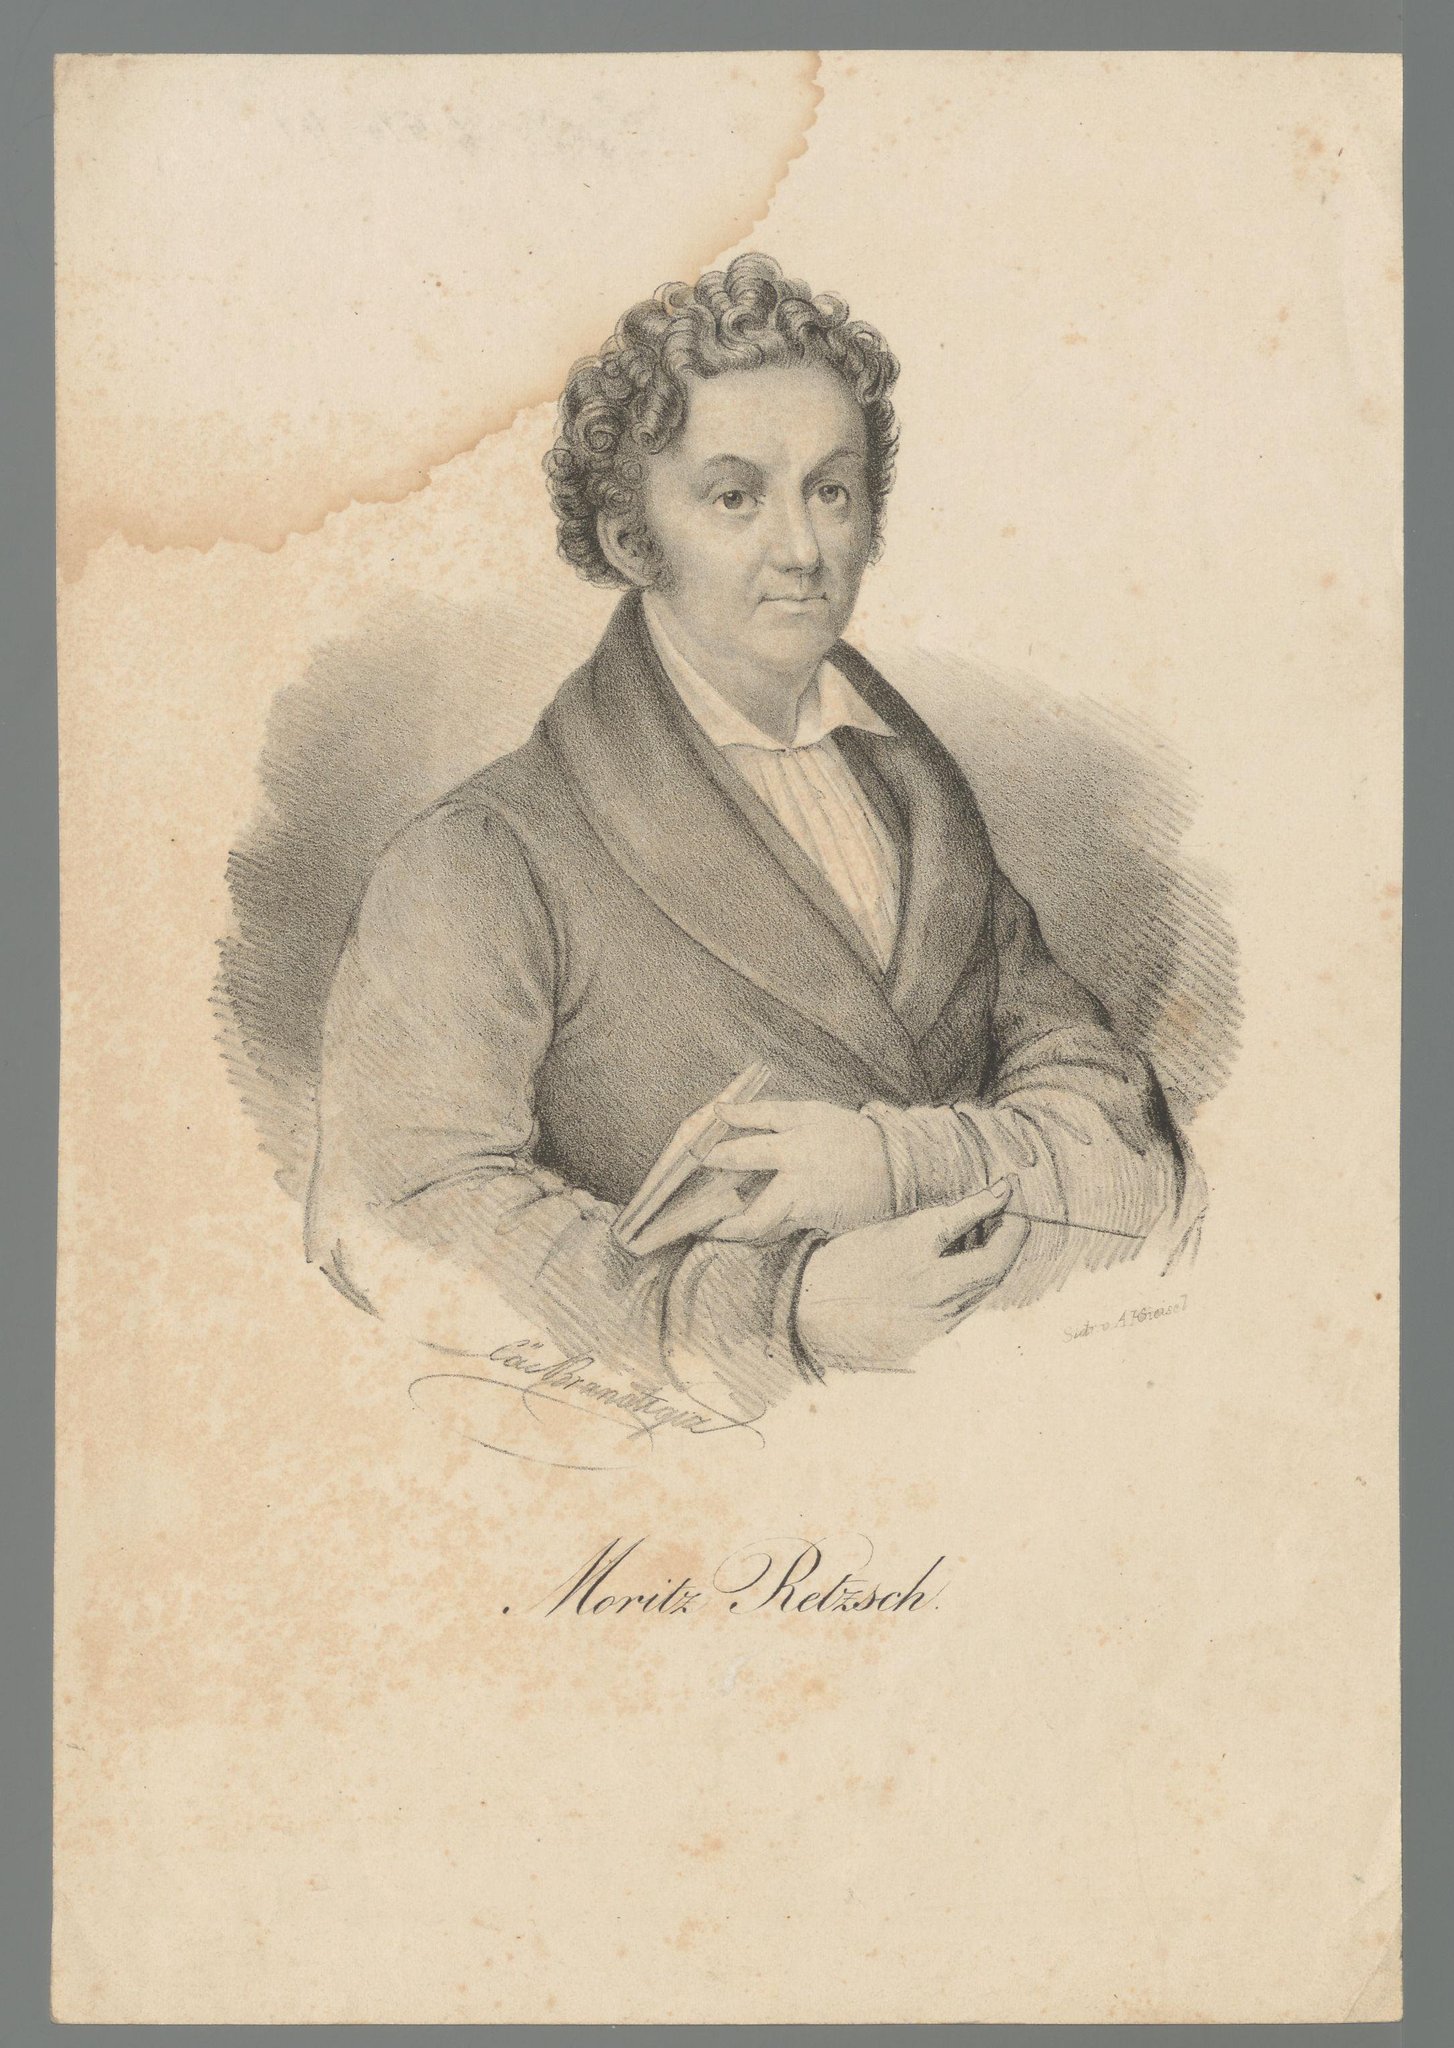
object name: print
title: Moritz Retzsch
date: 1829-1839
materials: paper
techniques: lithograph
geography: leipzig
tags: print maker, moritz retzsch, adult man, historical persons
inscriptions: collector's mark: Lugt 2760, inscription: ‘Portr. 60918/ Retzsch LB XXIV 443352’, collector's mark: Lugt 2228